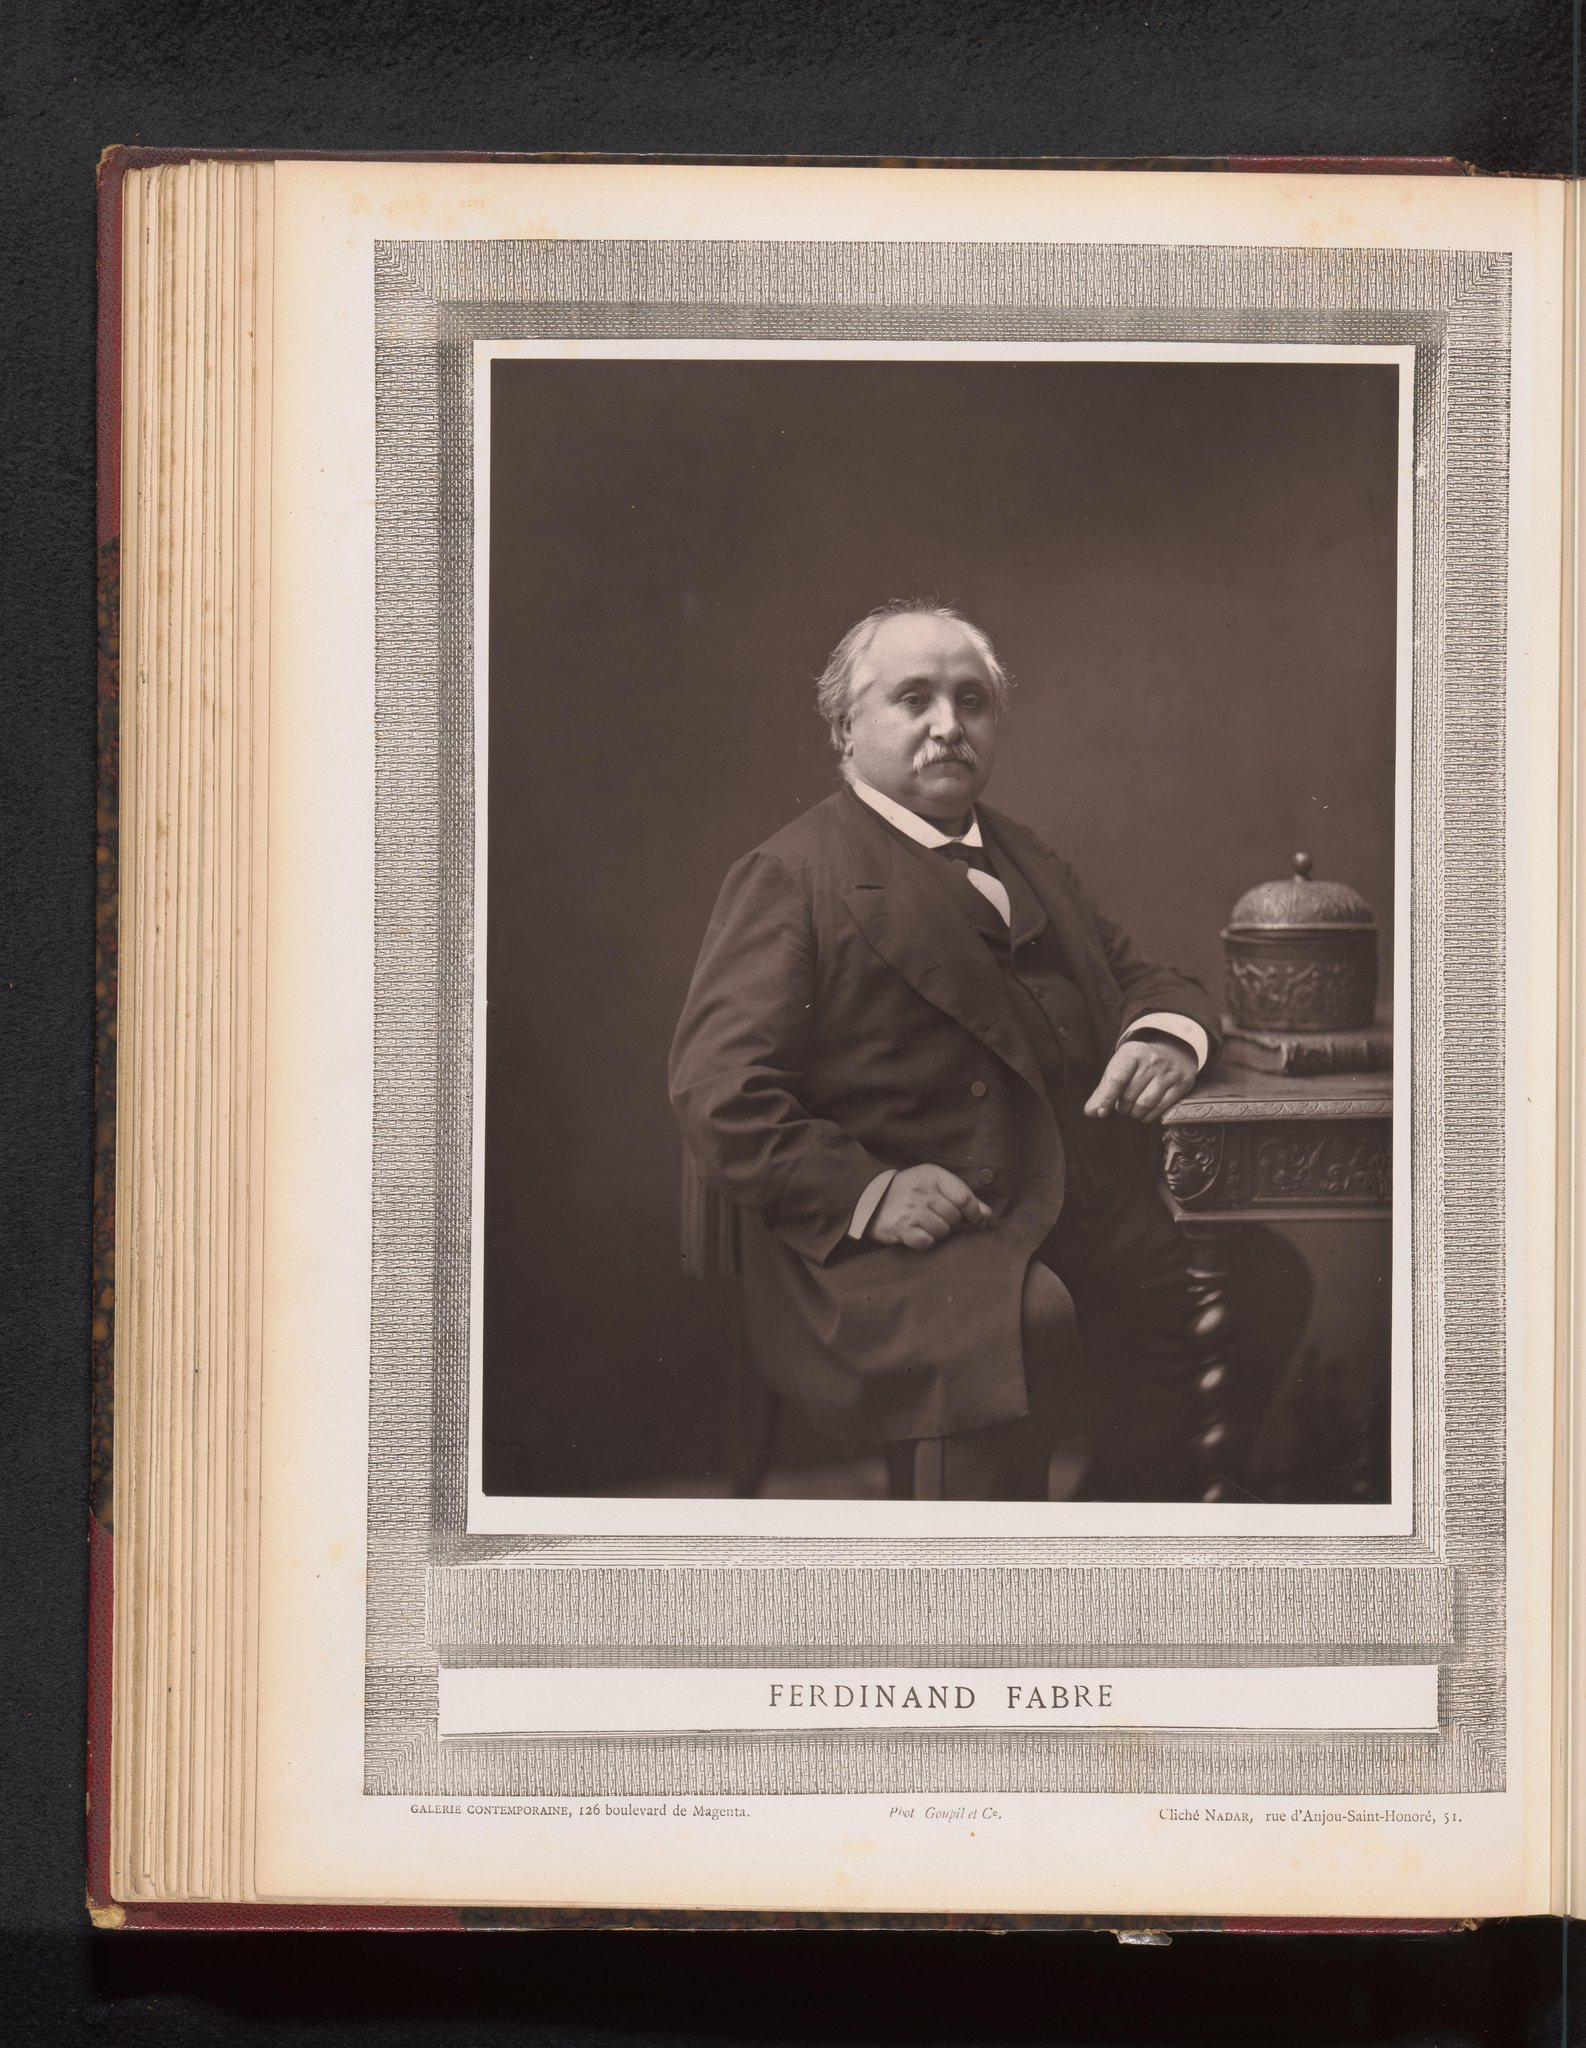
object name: photomechanical print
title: Ferdinand Fabre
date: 1871-1876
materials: paper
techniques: woodburytype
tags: paris, adult man, historical persons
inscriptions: inscription: ‘Galerie Contemporaine, 126 boulevard de Magenta.’